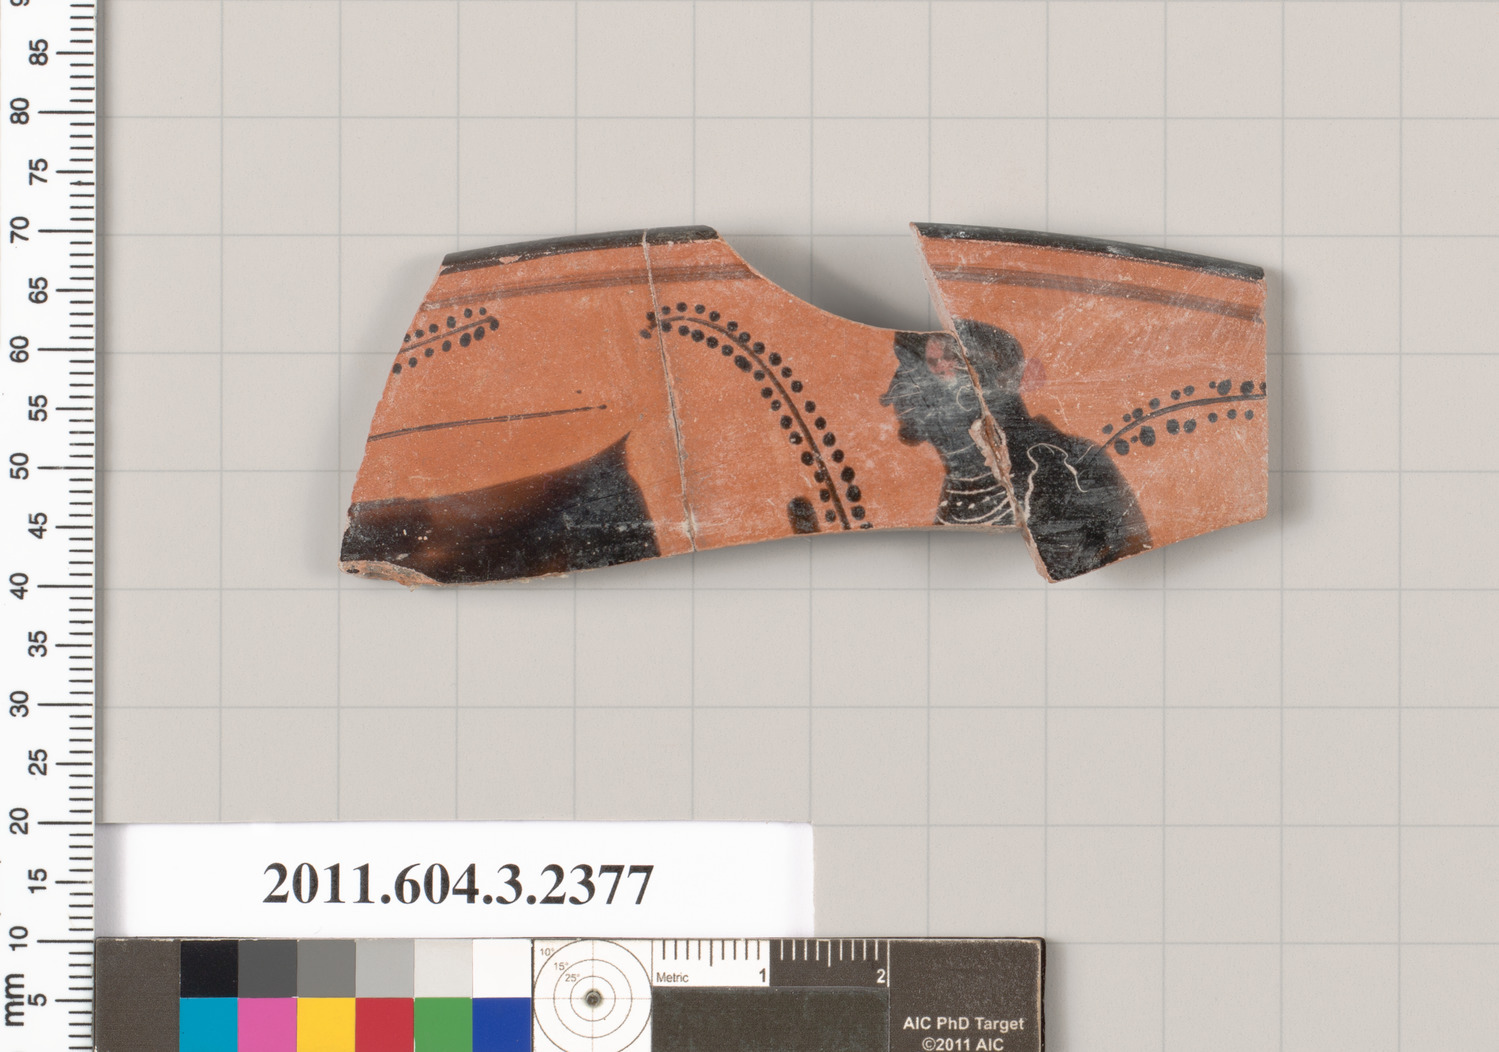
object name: kylix fragment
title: Terracotta rim fragment of a kylix: eye-cup (drinking cup)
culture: greek, attic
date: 540-520 BCE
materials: terracotta